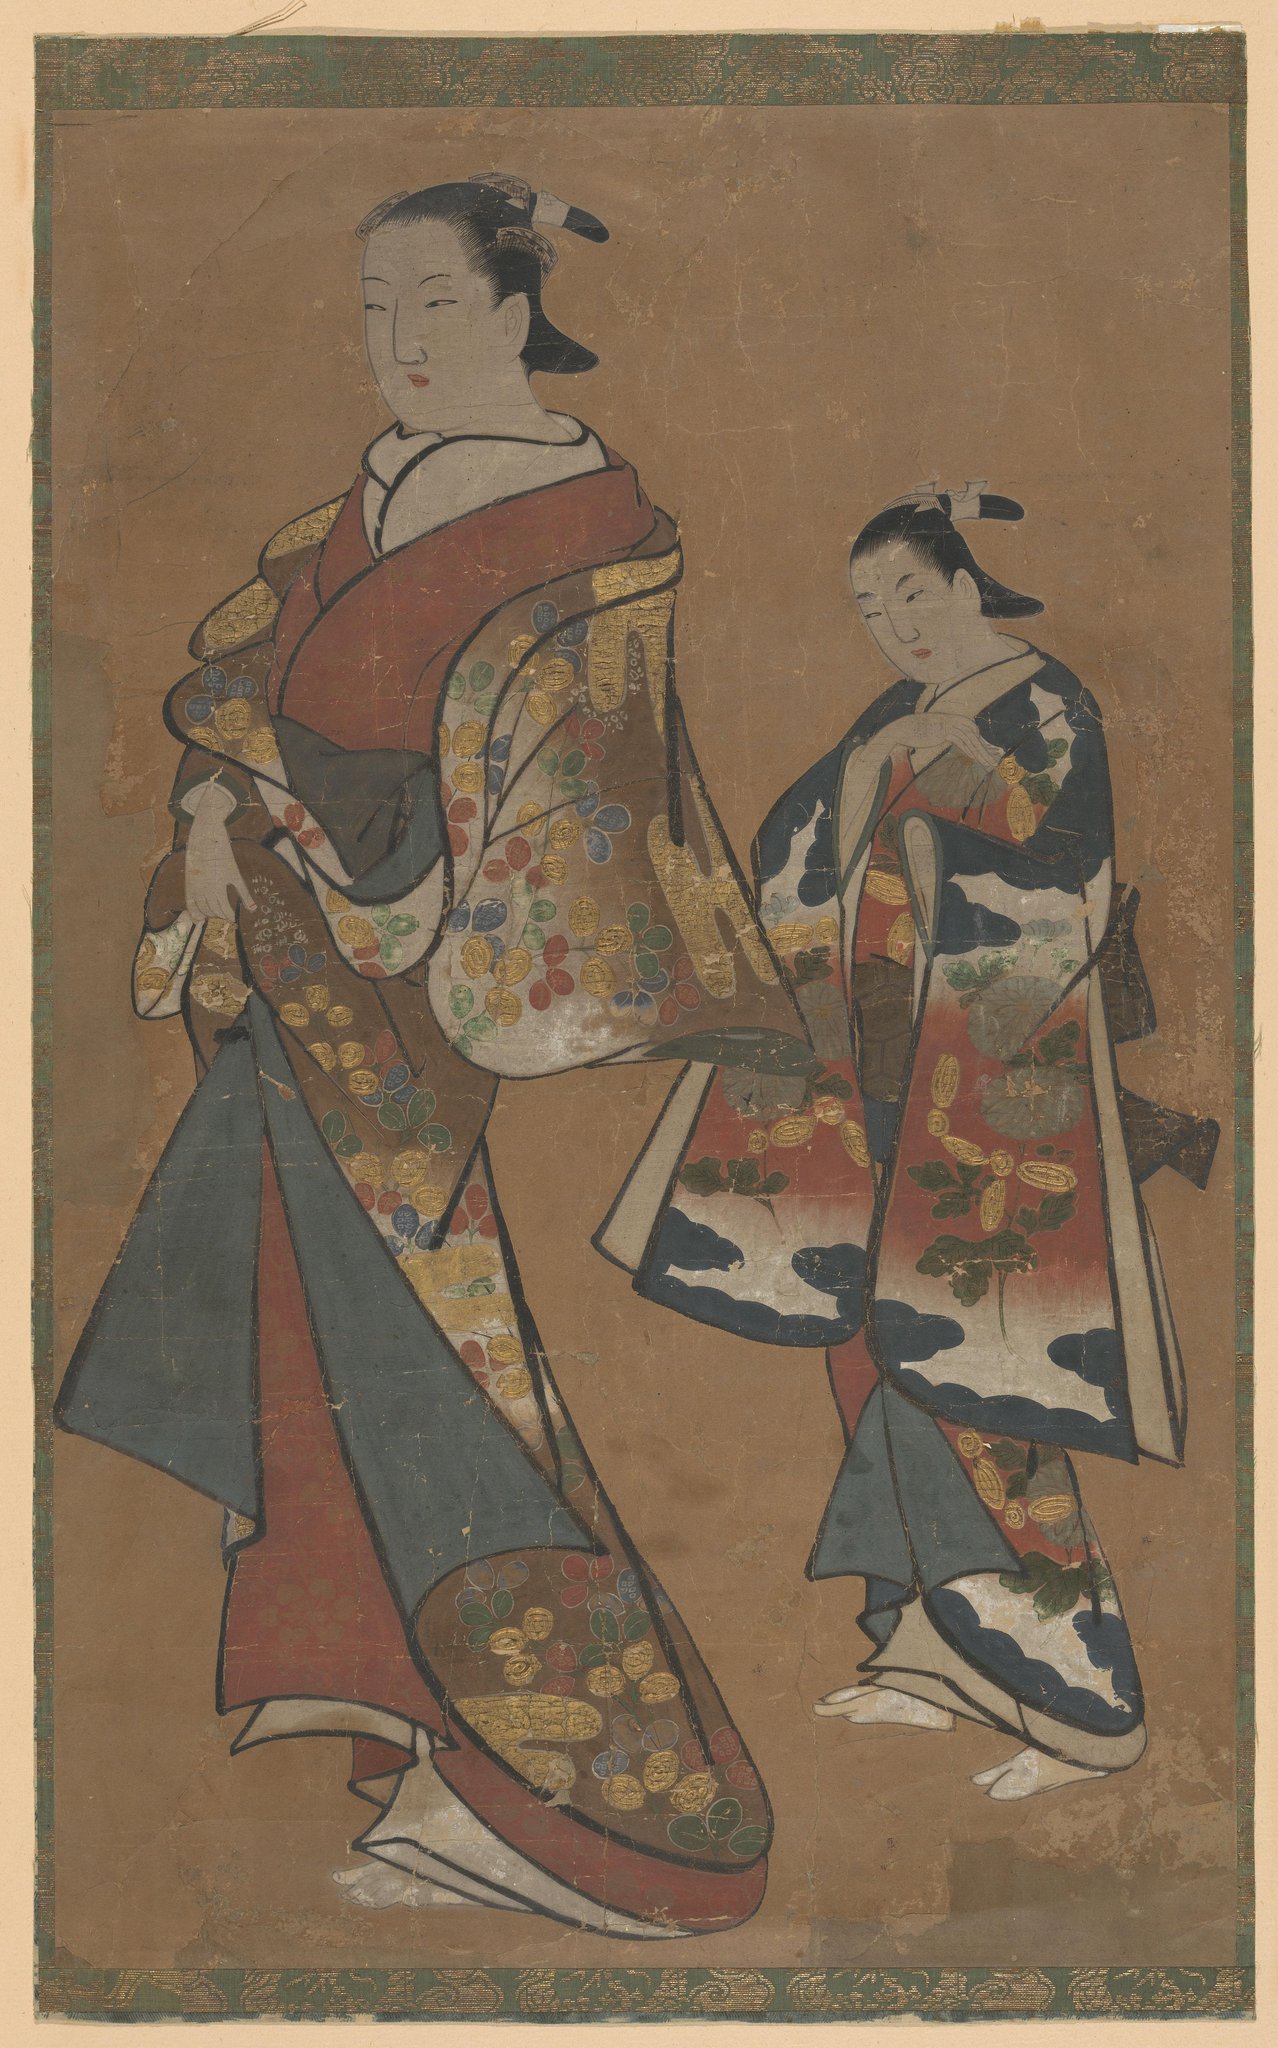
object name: drawing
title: Japanse vrouw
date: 1700-1800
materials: gold leaf, paint, paper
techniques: brush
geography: japan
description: Een japanse vrouw gevolgds door haar dienares. De kleding die zij dragen is versierd met bloemen en wolken in goud uitgevoerd. Op de achterzijde beplakt met beschreven vellen uit een oud boek.